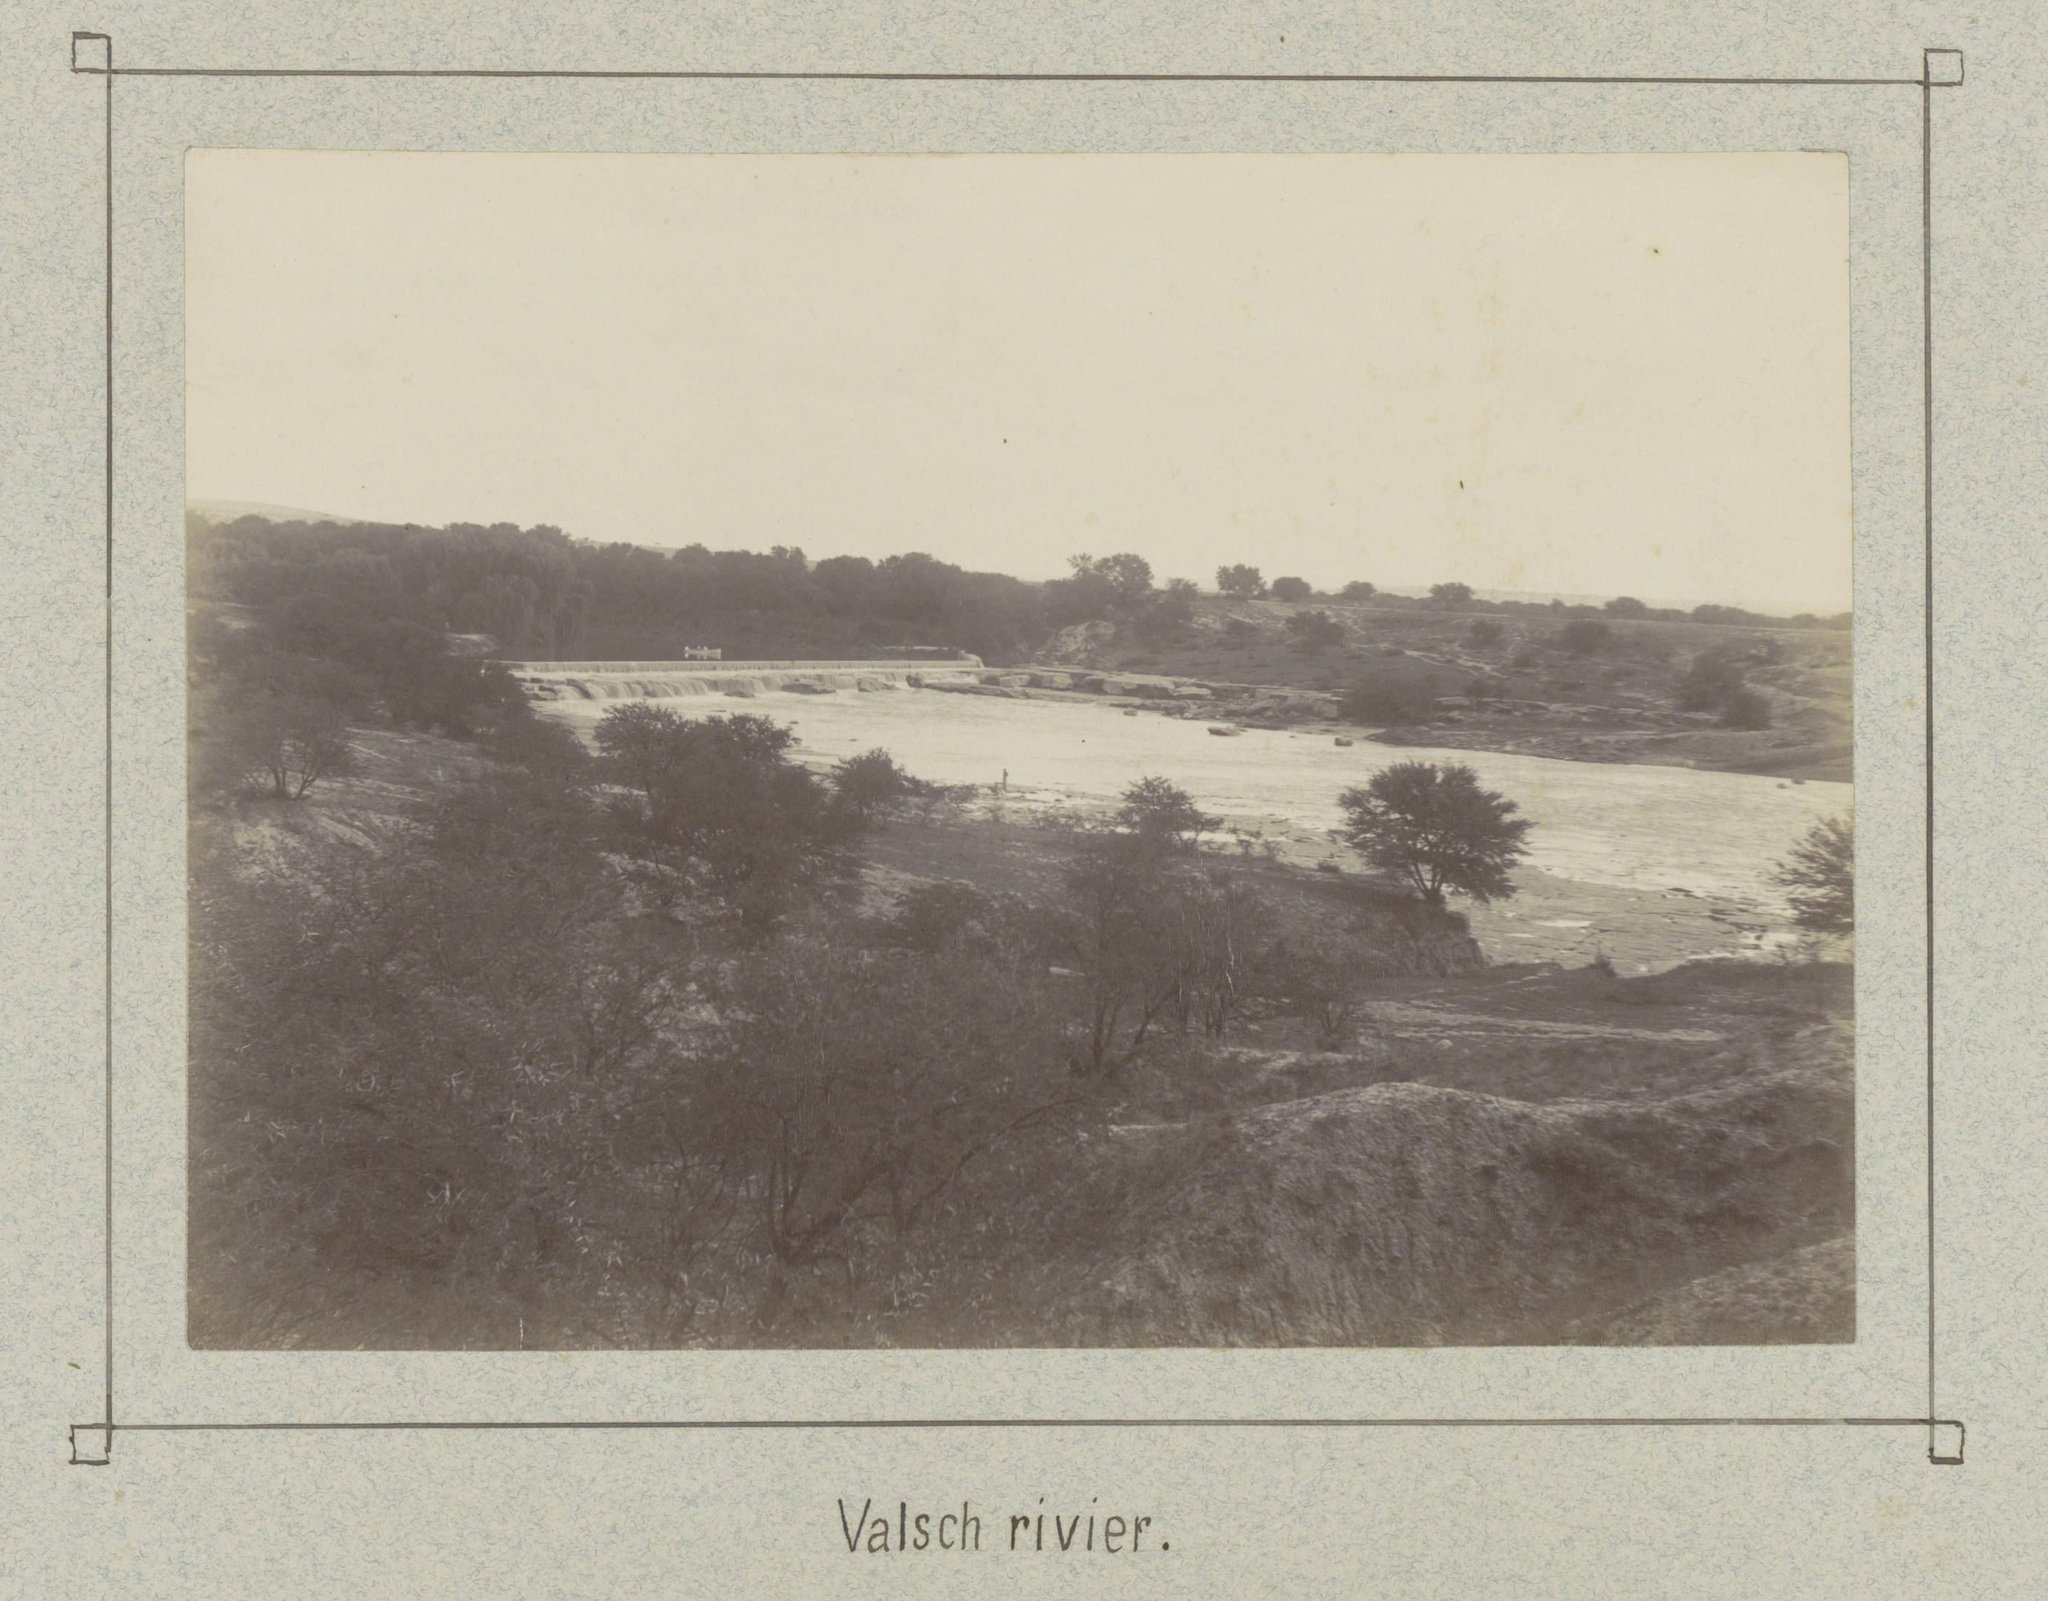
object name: photograph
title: Gezicht op de Valsrivier in Zuid-Afrika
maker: Anonymous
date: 1880-1900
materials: photographic support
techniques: albumen print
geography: south africa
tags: river (+ landscape with figures, staffage)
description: Onderdeel van Reisalbum met foto's van Zuid-Afrika, Madeira, Portugal, Frankrijk en Duitsland.